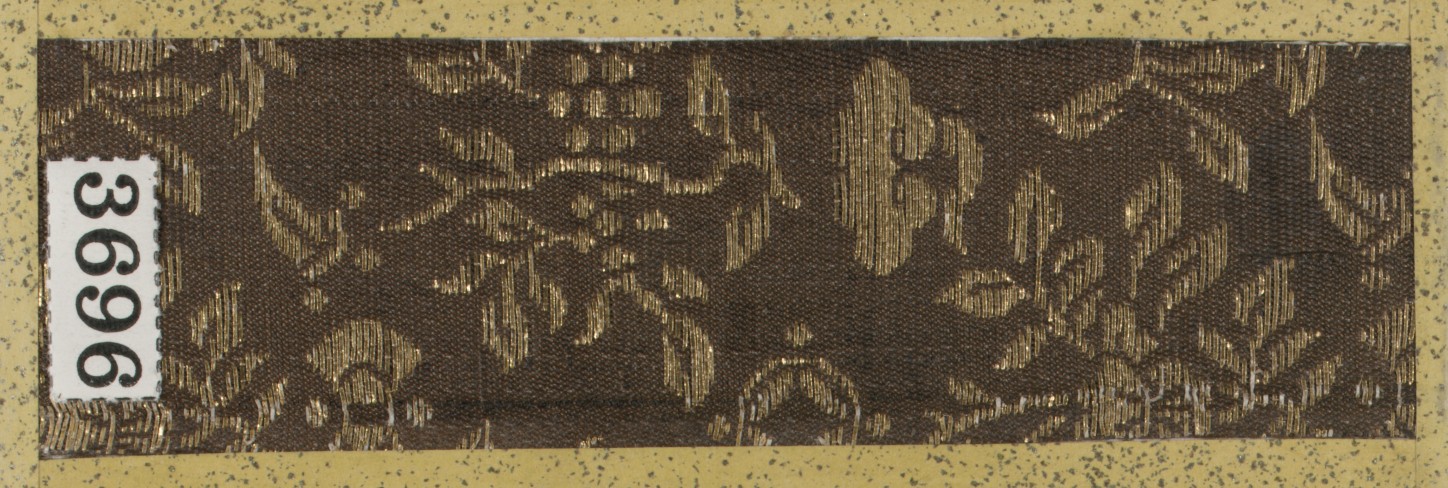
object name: sample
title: Textile Sample from Sample Book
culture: japanese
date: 1801-1900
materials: silk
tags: flowers